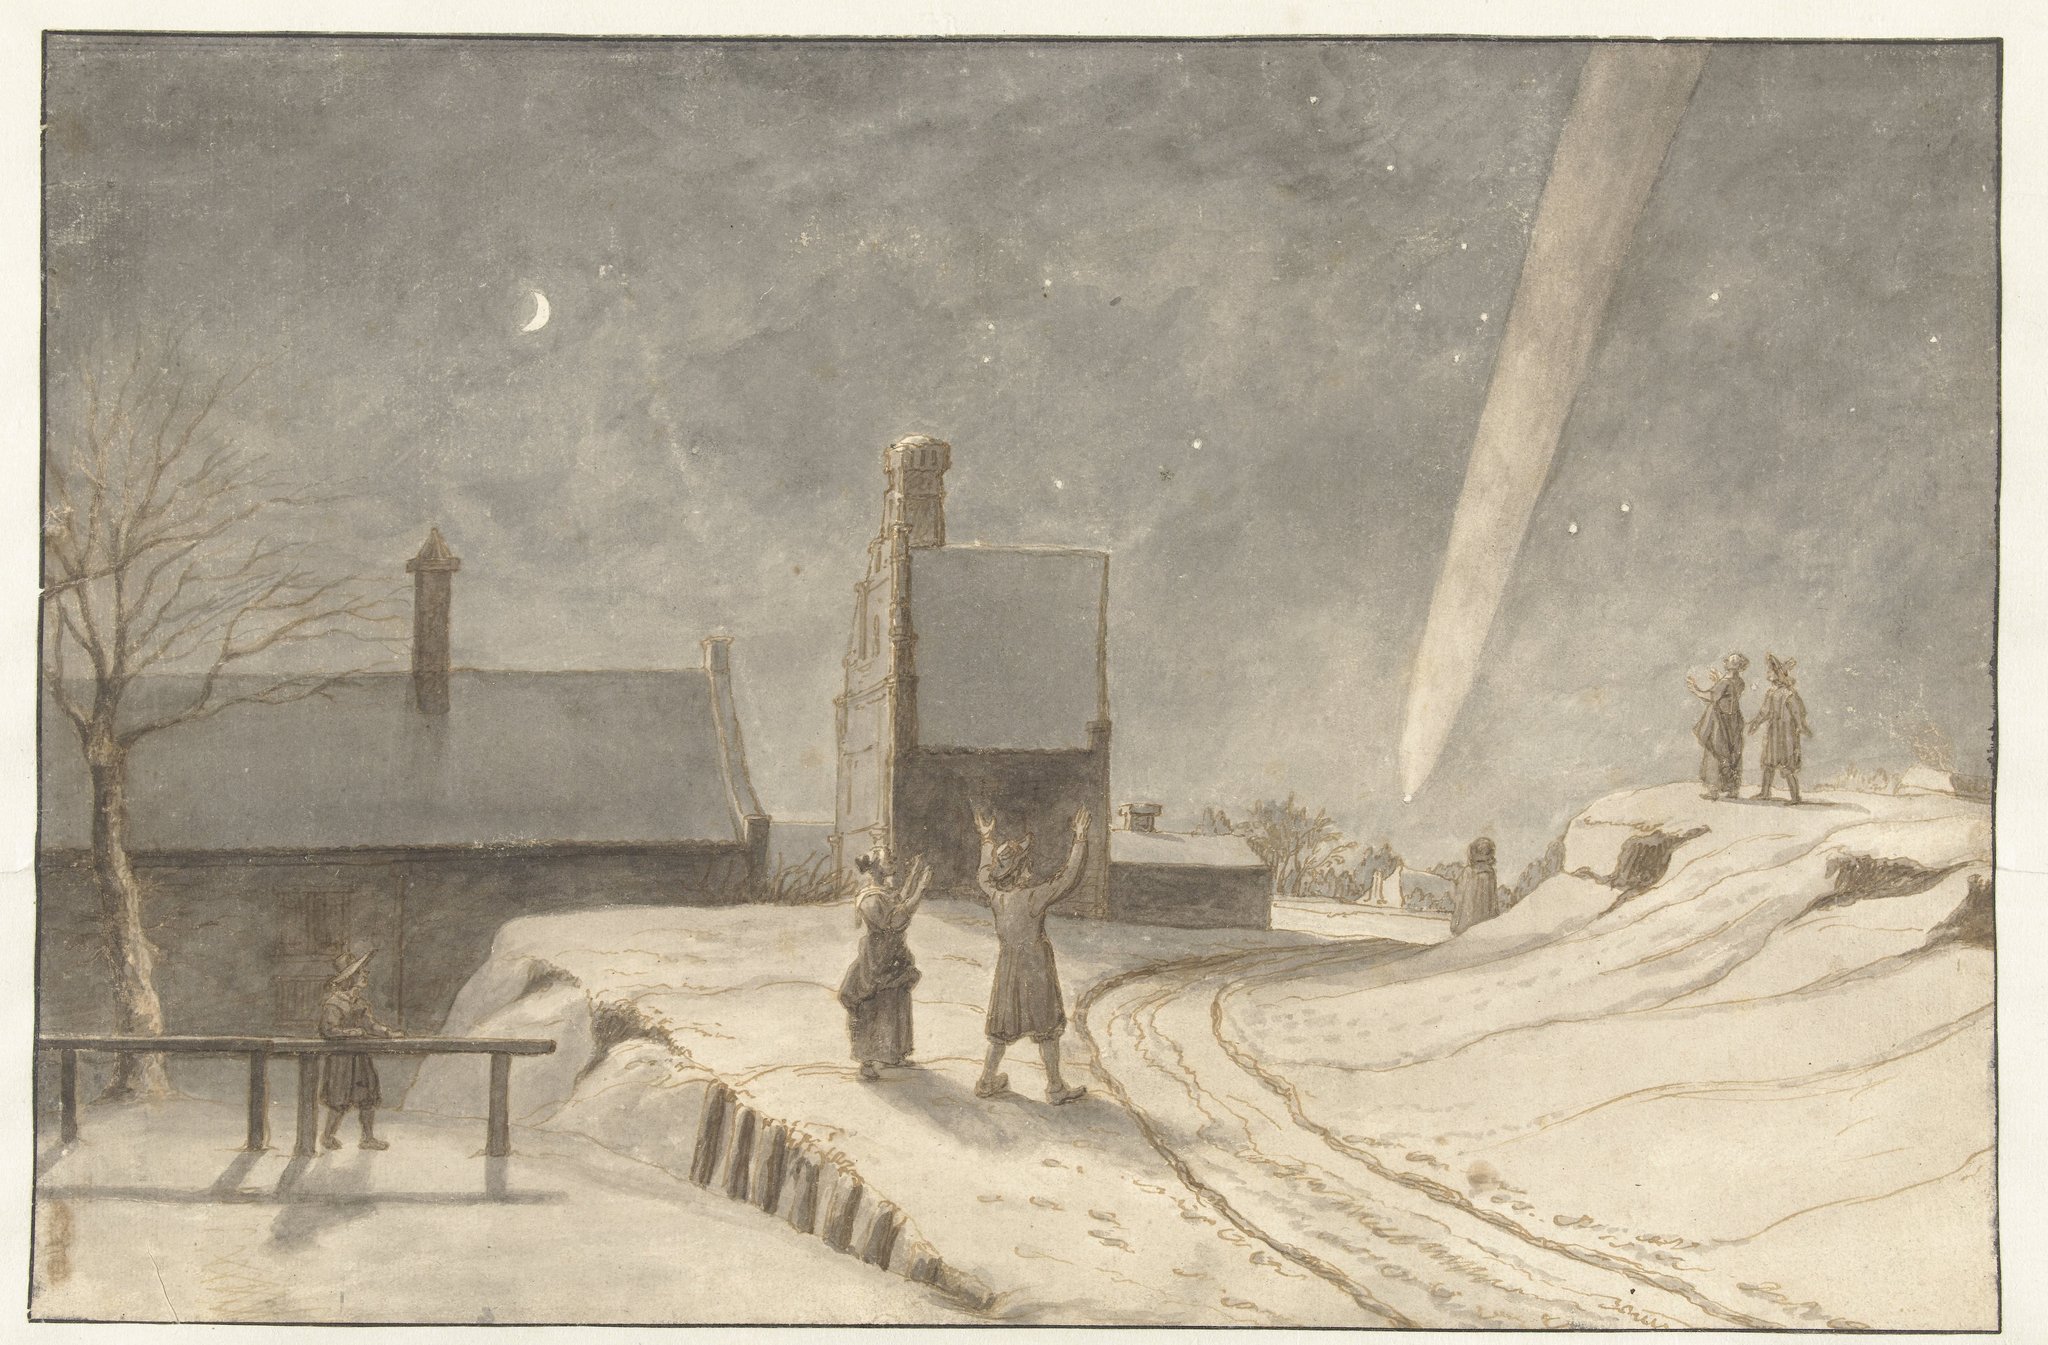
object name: drawing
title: Staartster boven Alkmaar, 1681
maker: lambert doomer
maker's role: draughtsman, painter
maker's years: 1622-1700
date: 1601-1681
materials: chalk, ink, paper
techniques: brush, pen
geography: northern netherlands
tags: comet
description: Nachtlandschap met de grote komeet (staartster) gezien op een veld buiten de Geesterpoort te Alkmaar in januari 1681. Enkele toekijkers heffen de armen ten hemel.